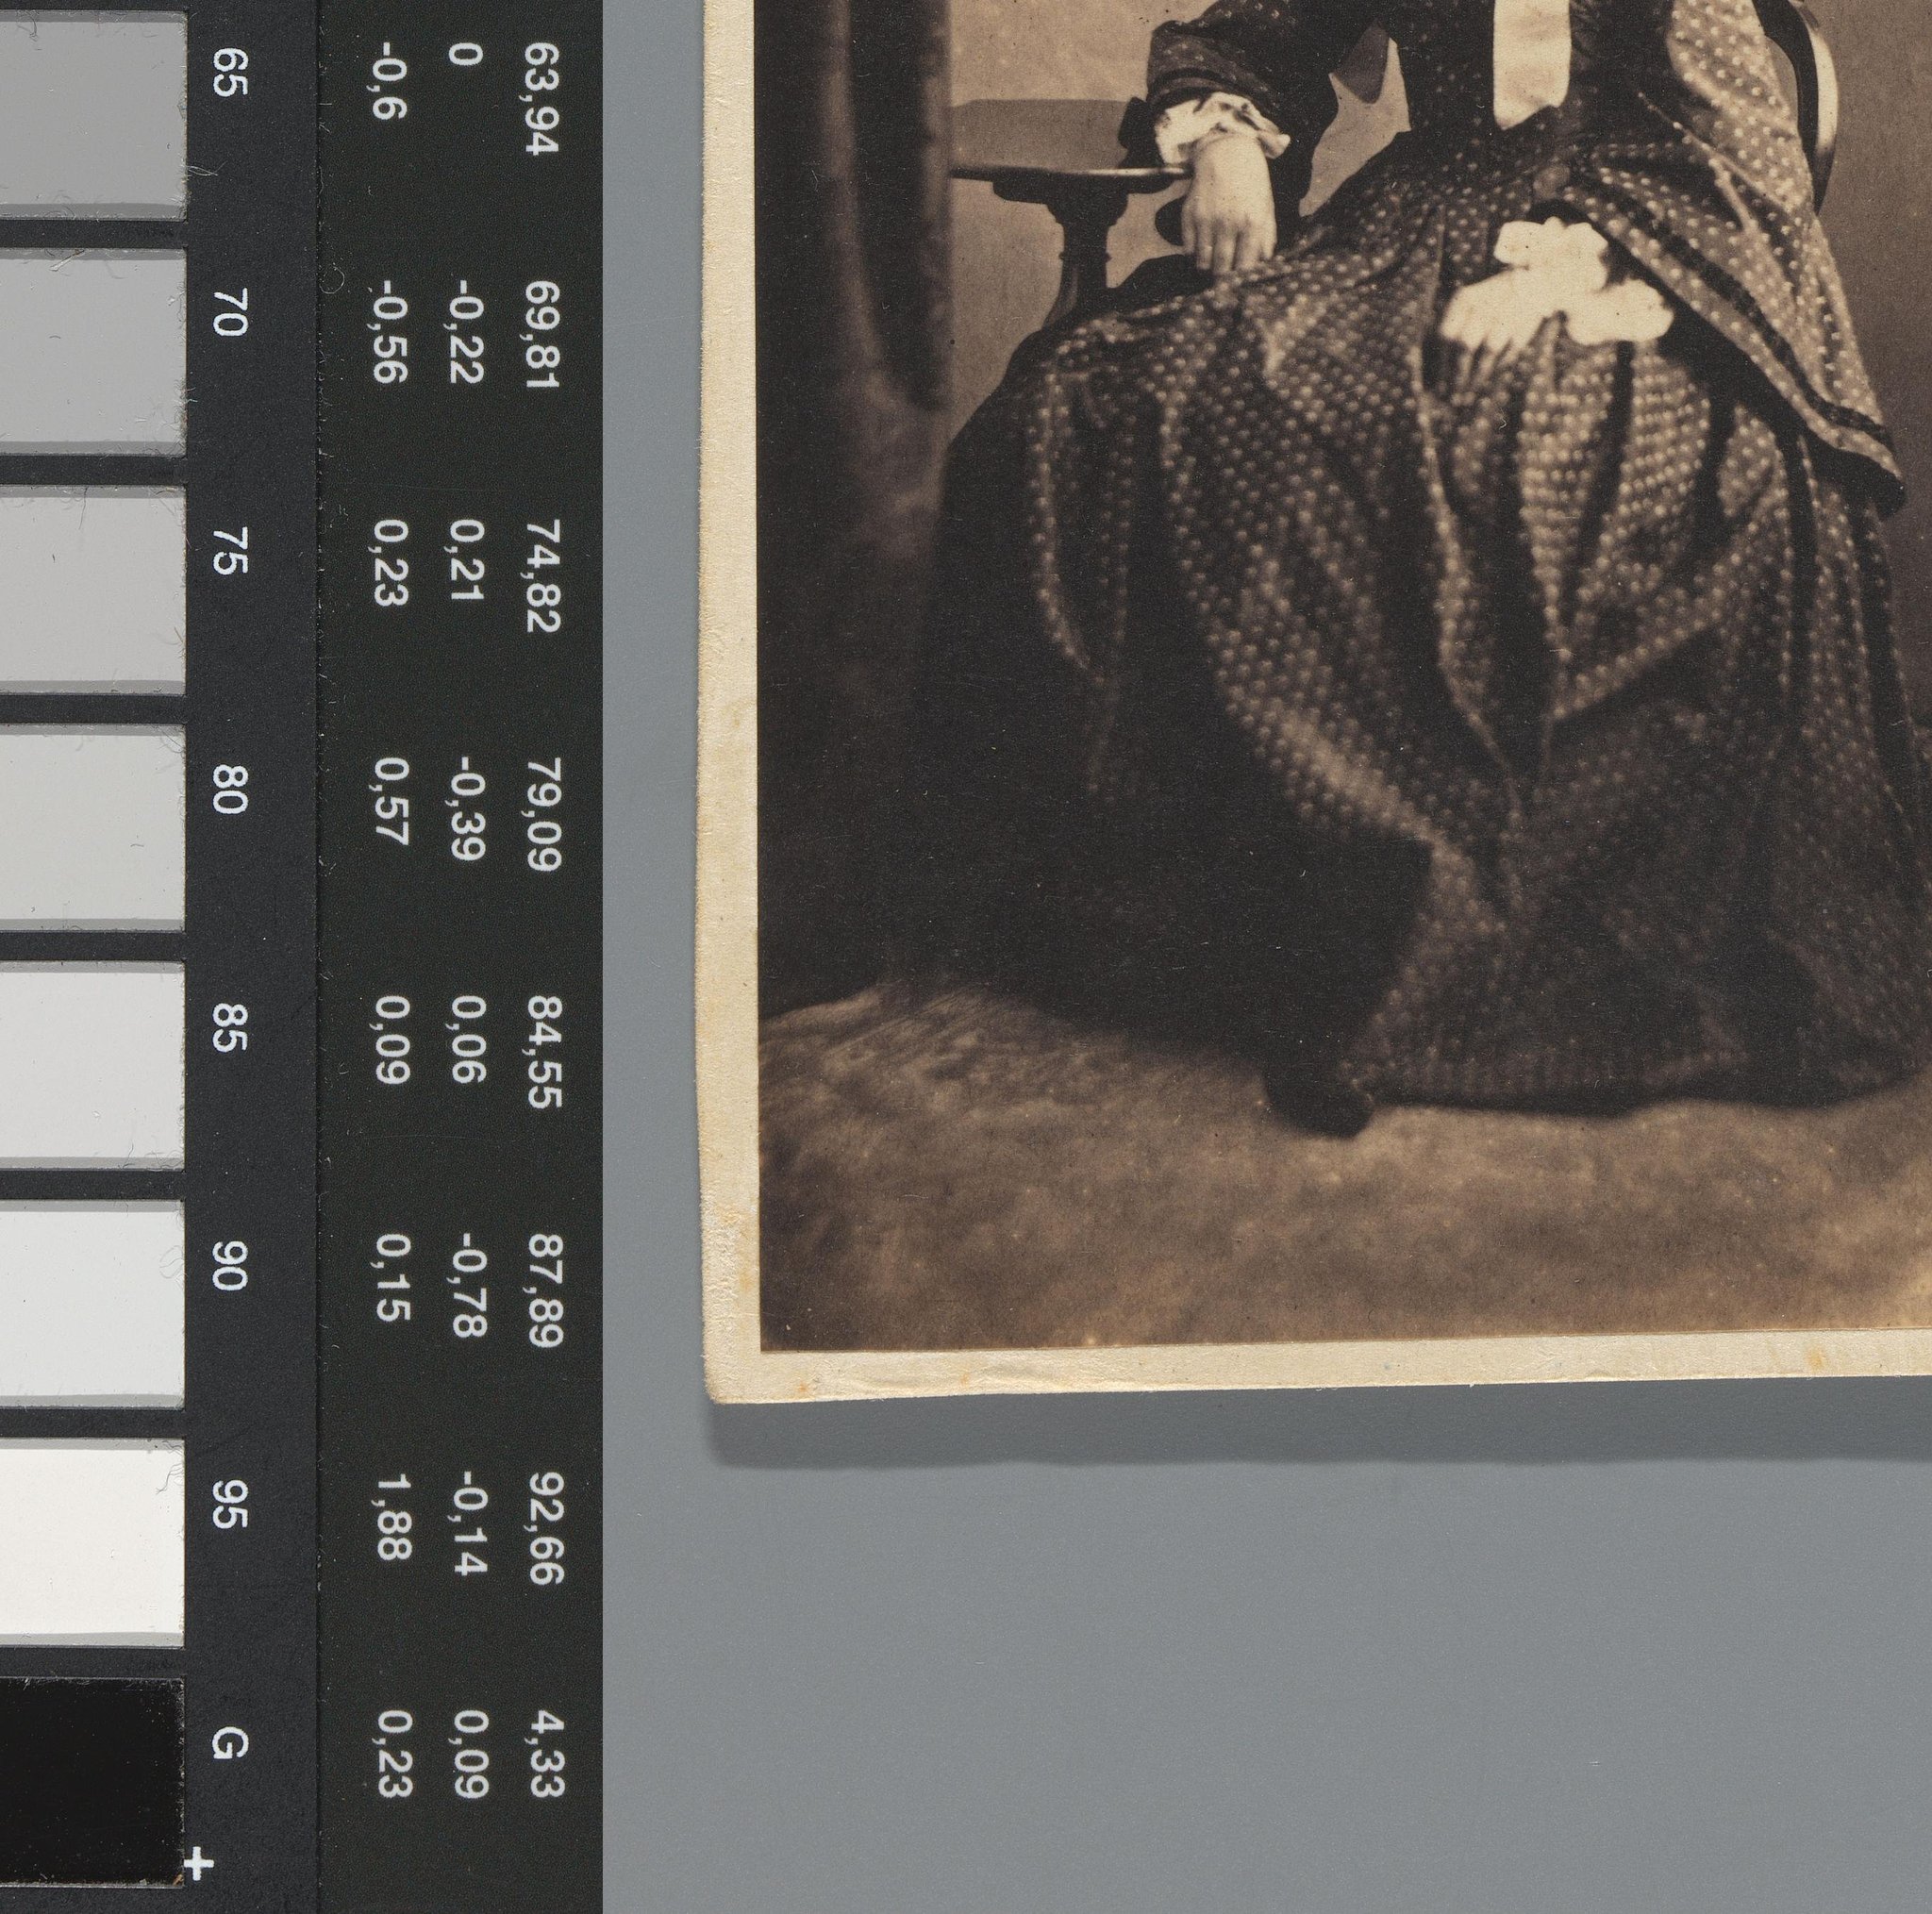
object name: carte de visite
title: Portret van Emilia Maria Theresia van Kerckhoff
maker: a. böeseken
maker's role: fotograaf, lithograaf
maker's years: 1834-1919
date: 1855-1910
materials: cardboard, photographic support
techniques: albumen print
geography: rotterdam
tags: emilia maria theresia van kerckhoff